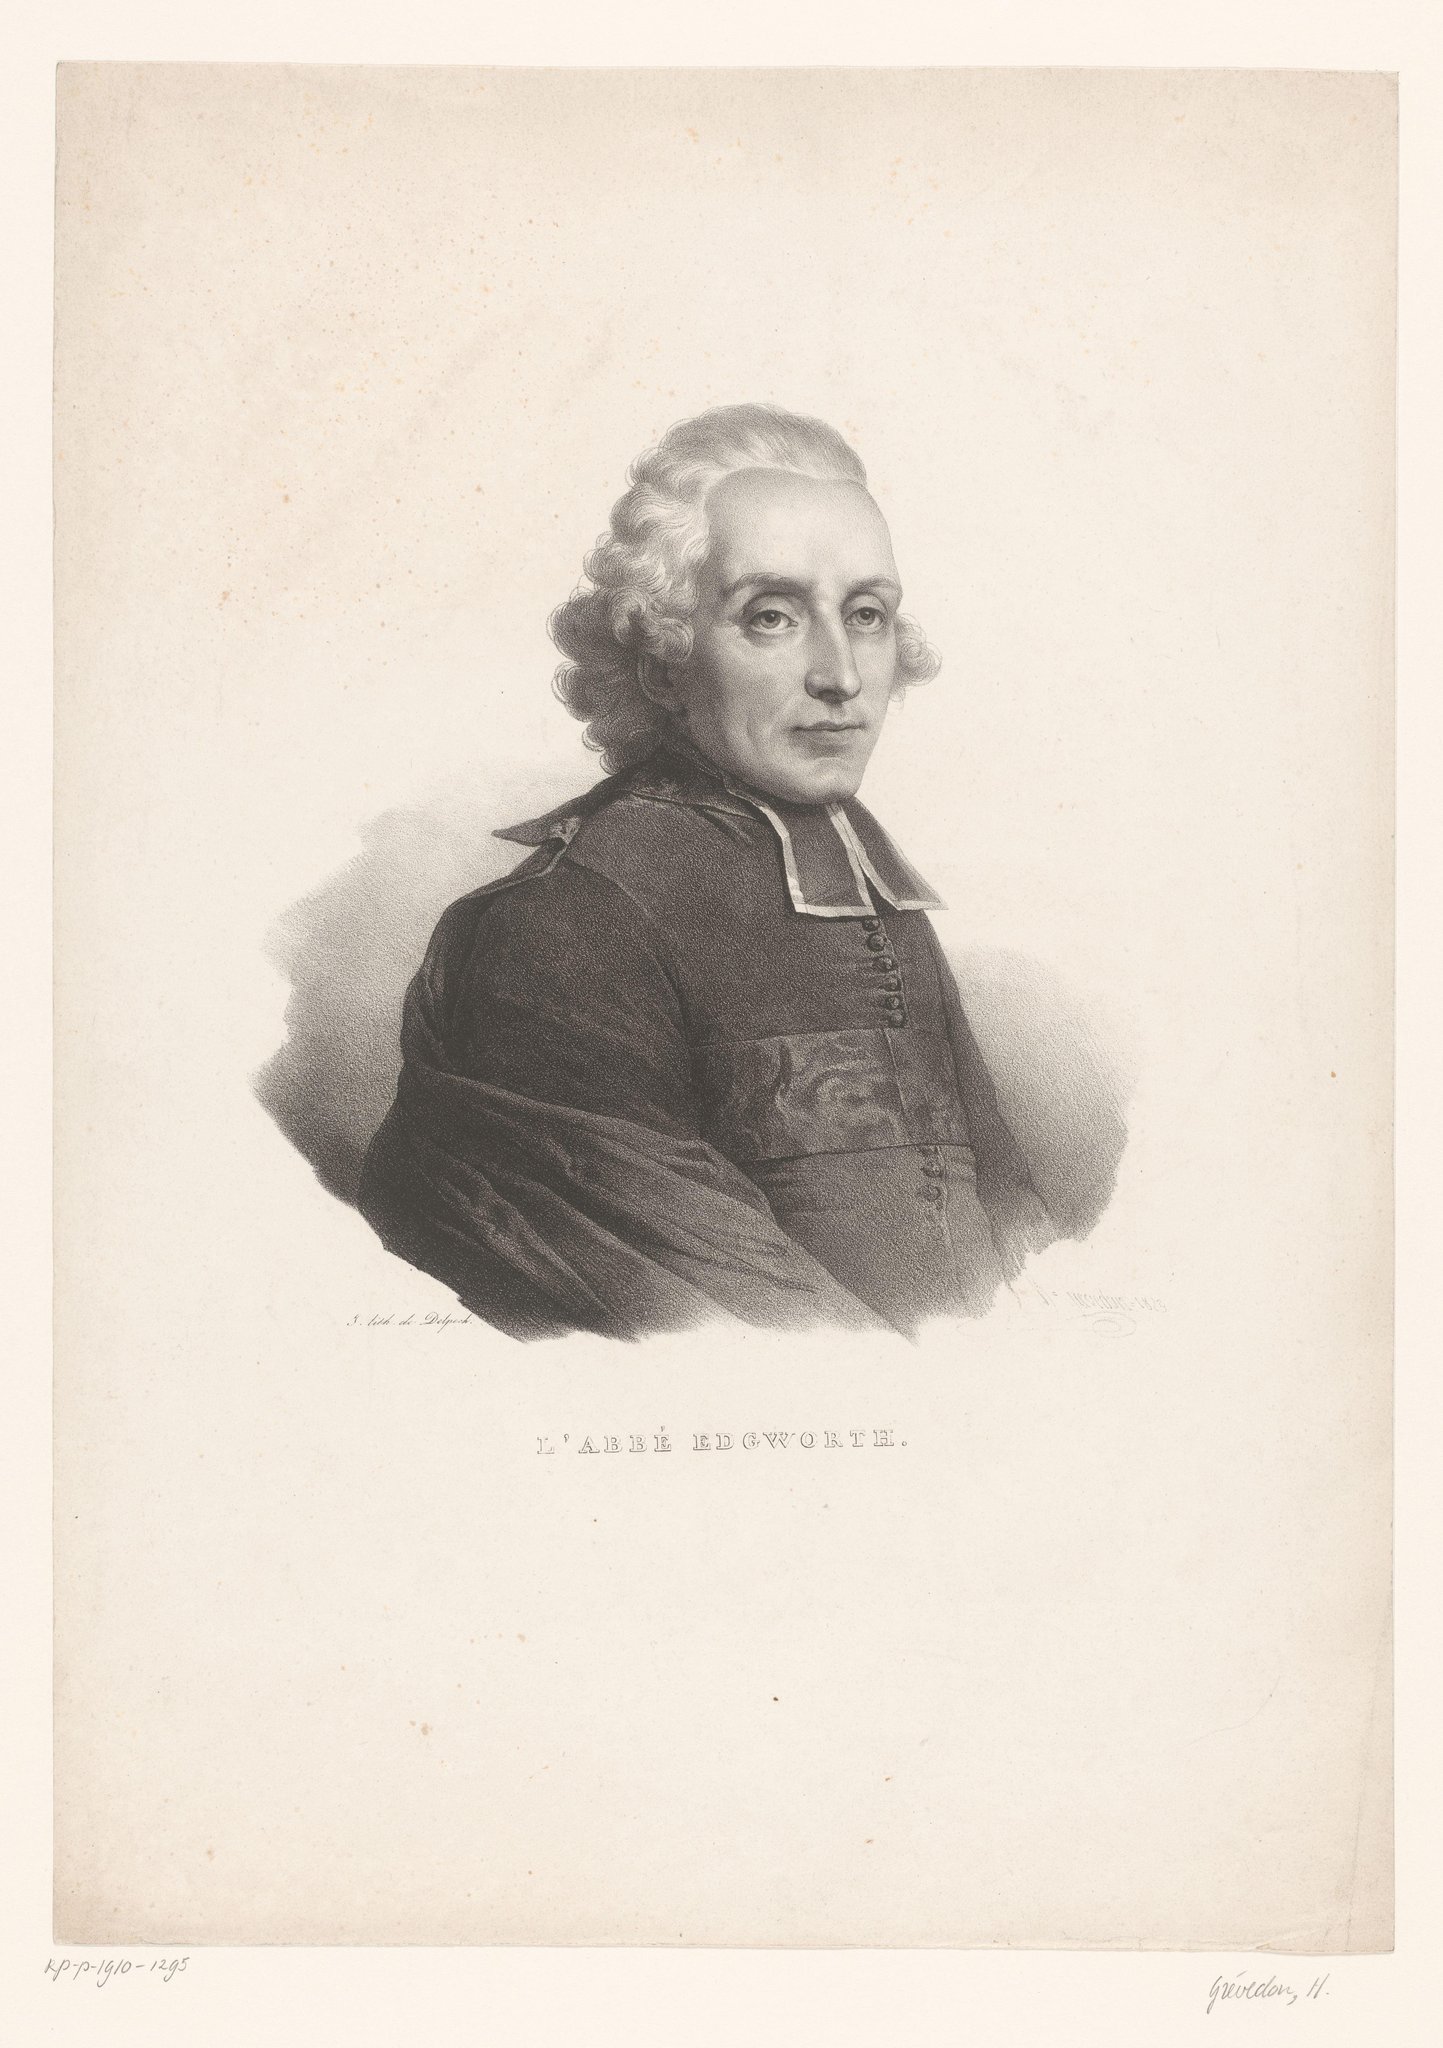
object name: print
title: L'abbé Edgworth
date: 1825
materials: paper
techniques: lithograph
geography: paris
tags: priest, historical persons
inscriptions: collector's mark: Lugt 2228a